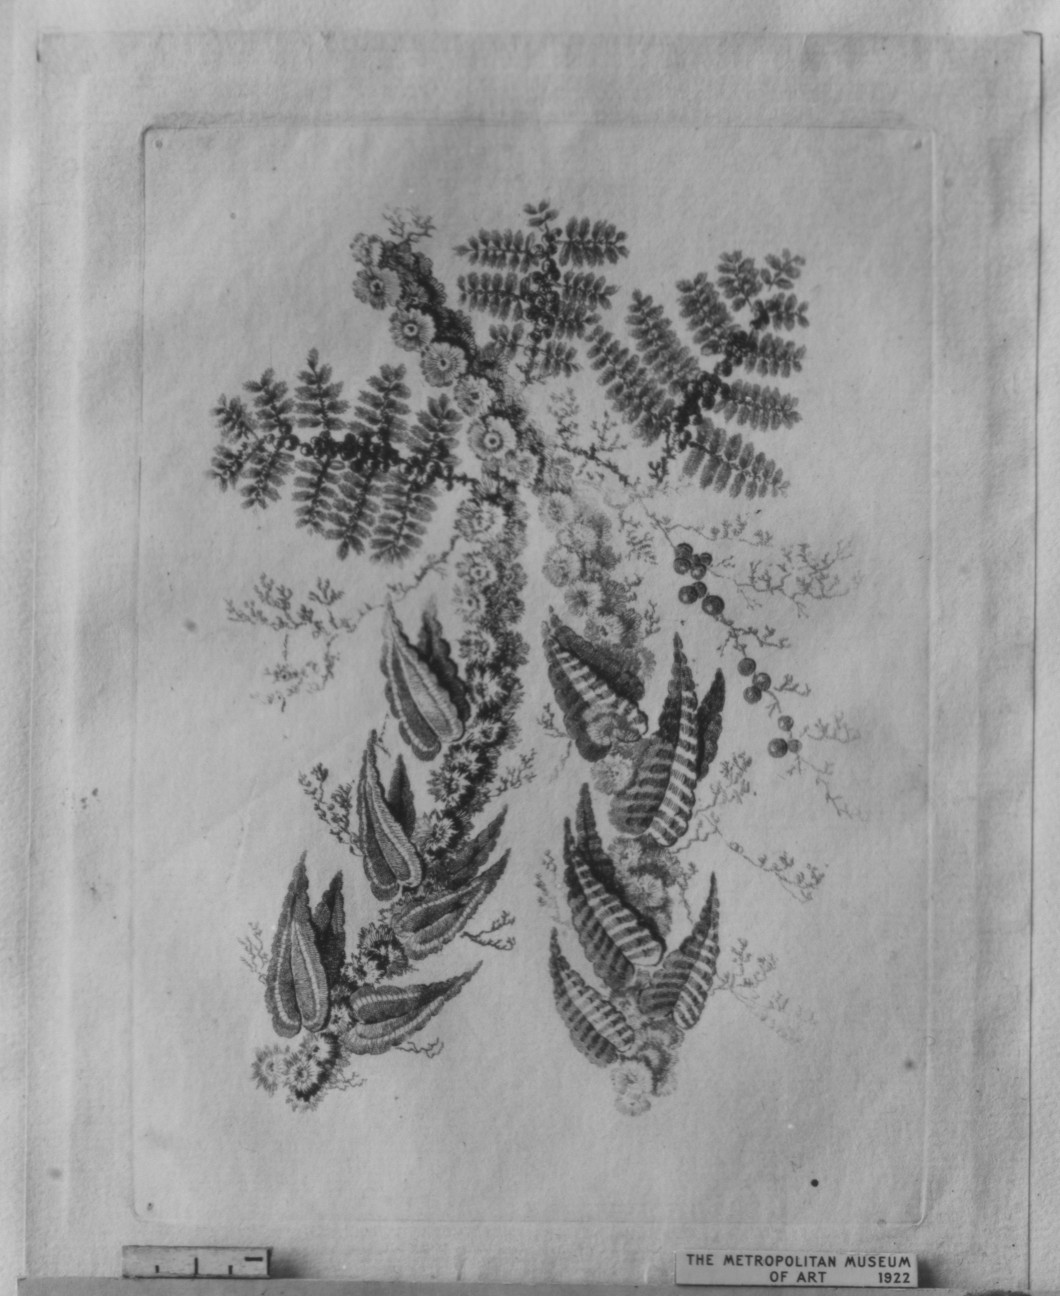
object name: print ornament architecture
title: Flowers, from "Nouvelle Suite de Cahiers de Fleurs idéales a l'usage des dessinateurs et des peintres"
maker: jean pillement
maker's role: artist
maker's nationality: french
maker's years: 1728-1808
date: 1790-1799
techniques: etching, lithography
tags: ornament